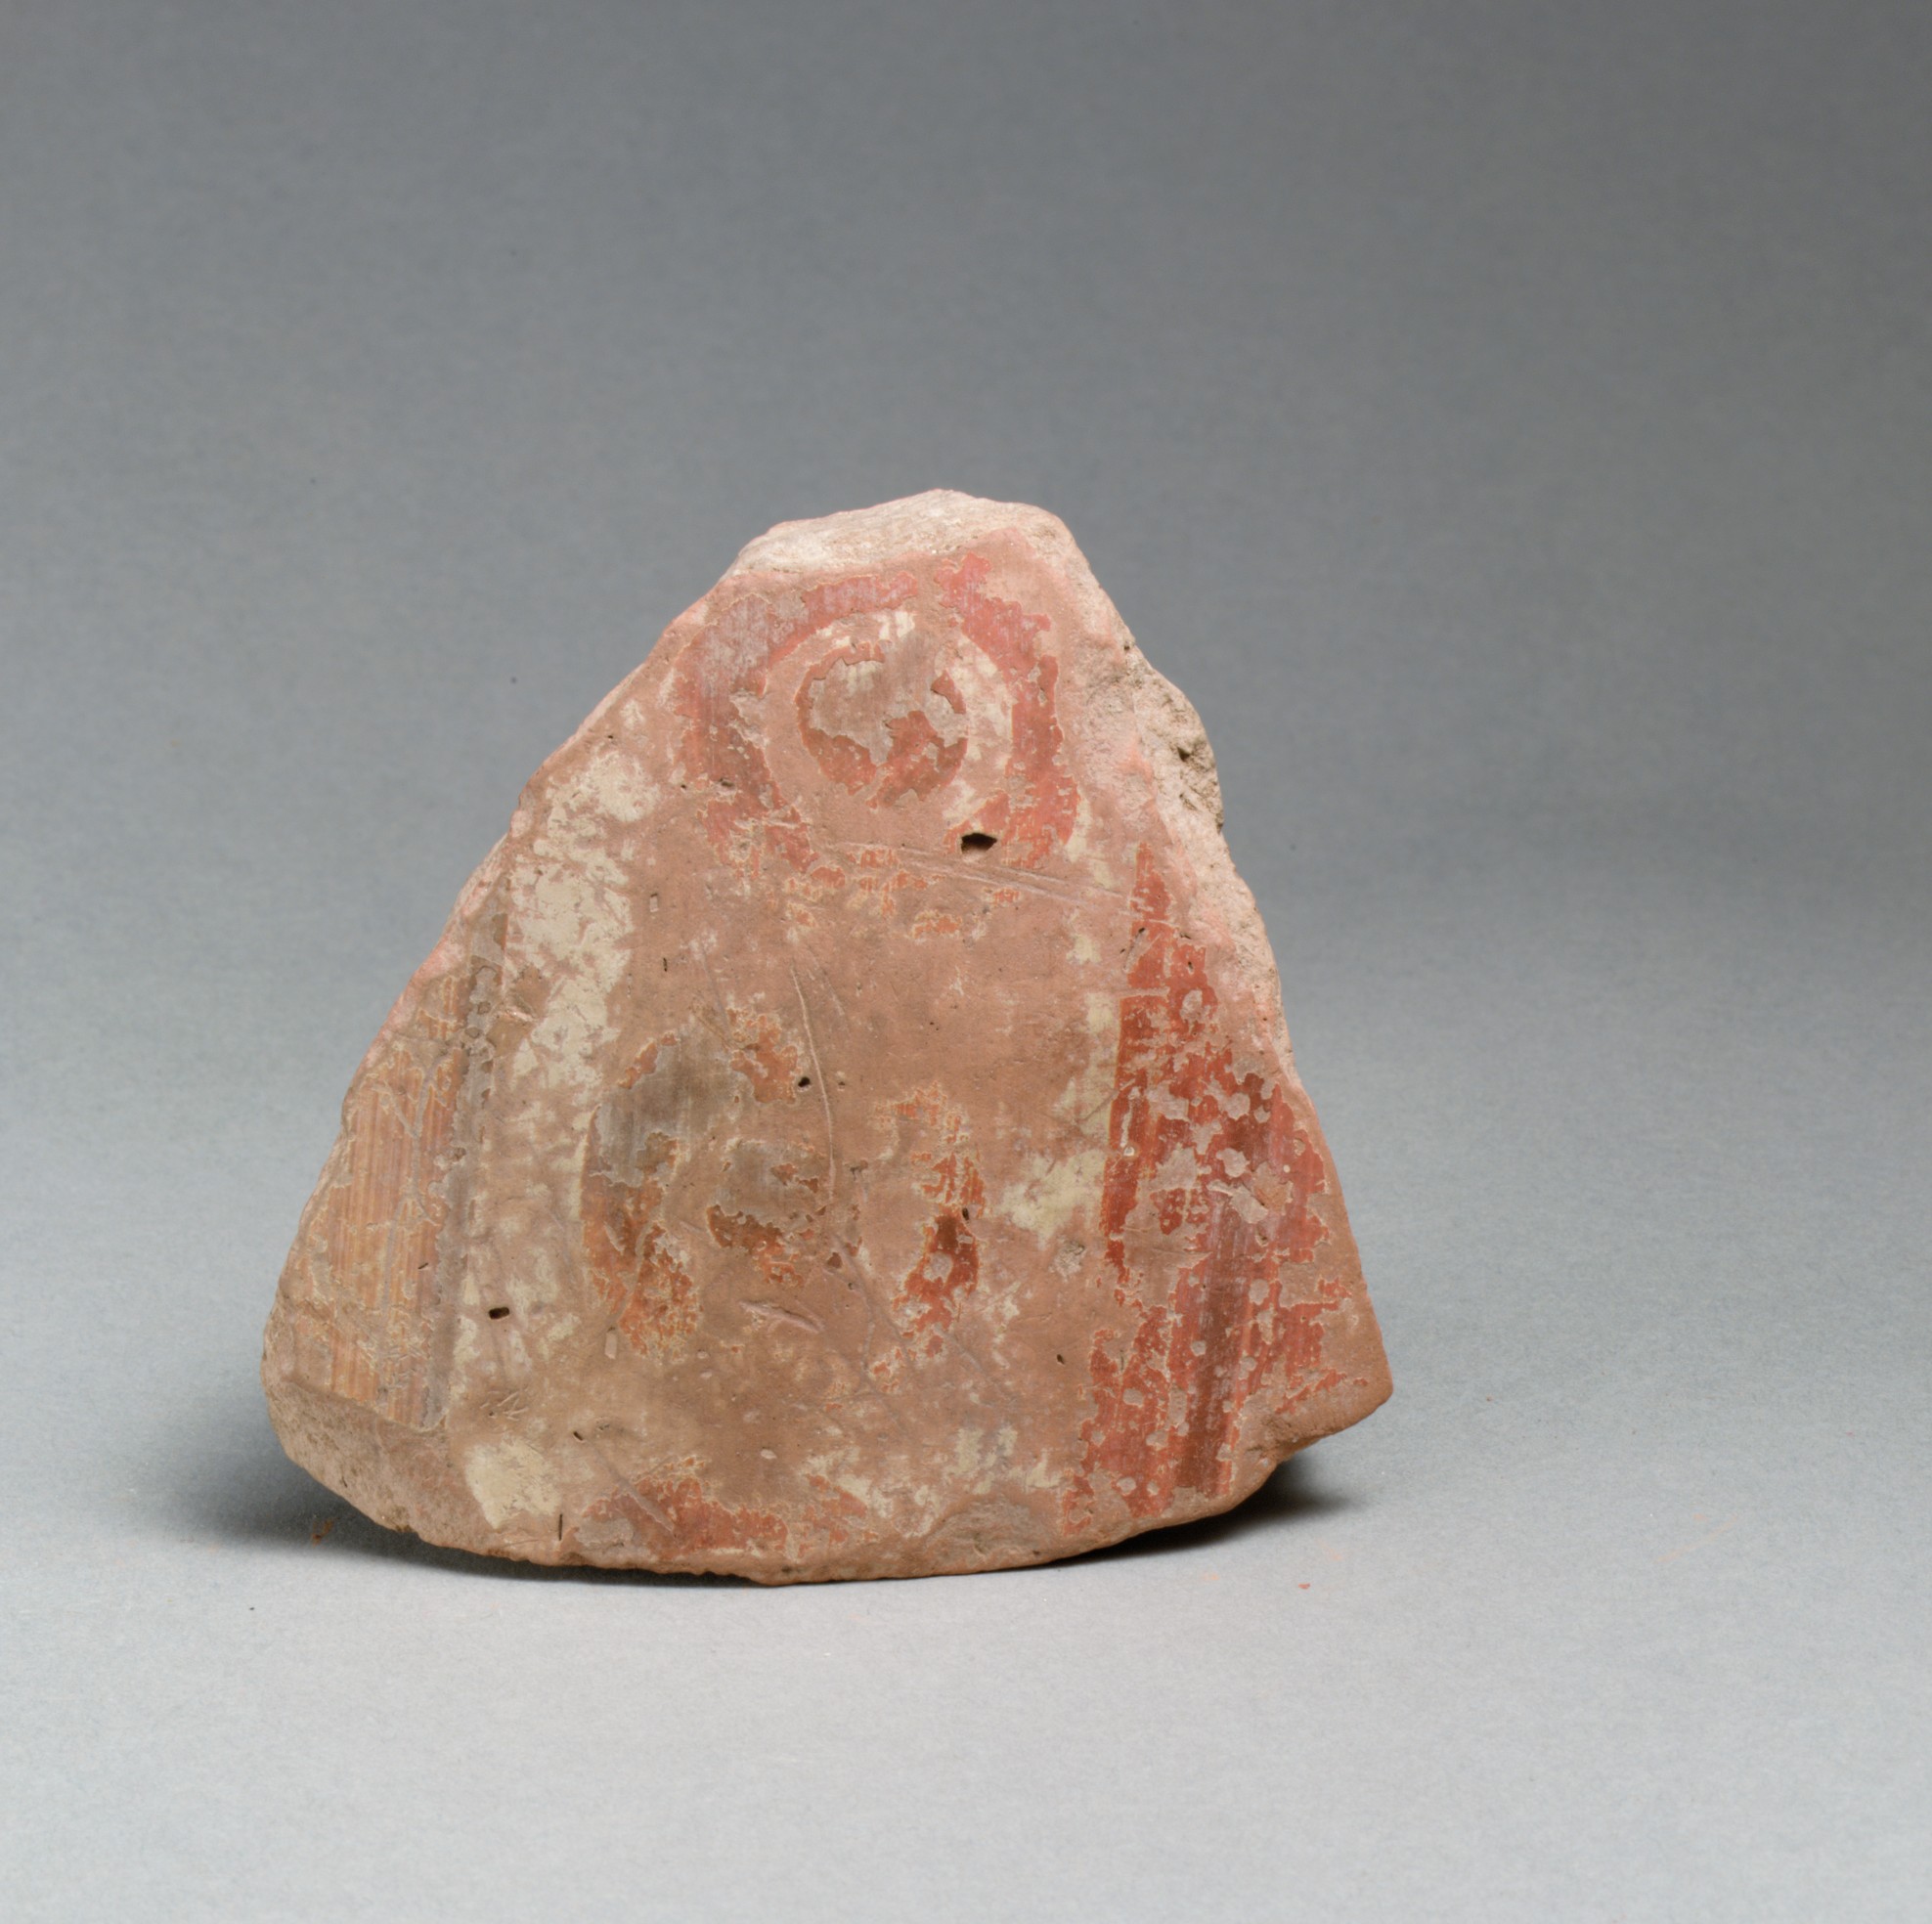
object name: vase fragment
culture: greek or lydian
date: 900-30 BCE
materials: terracotta